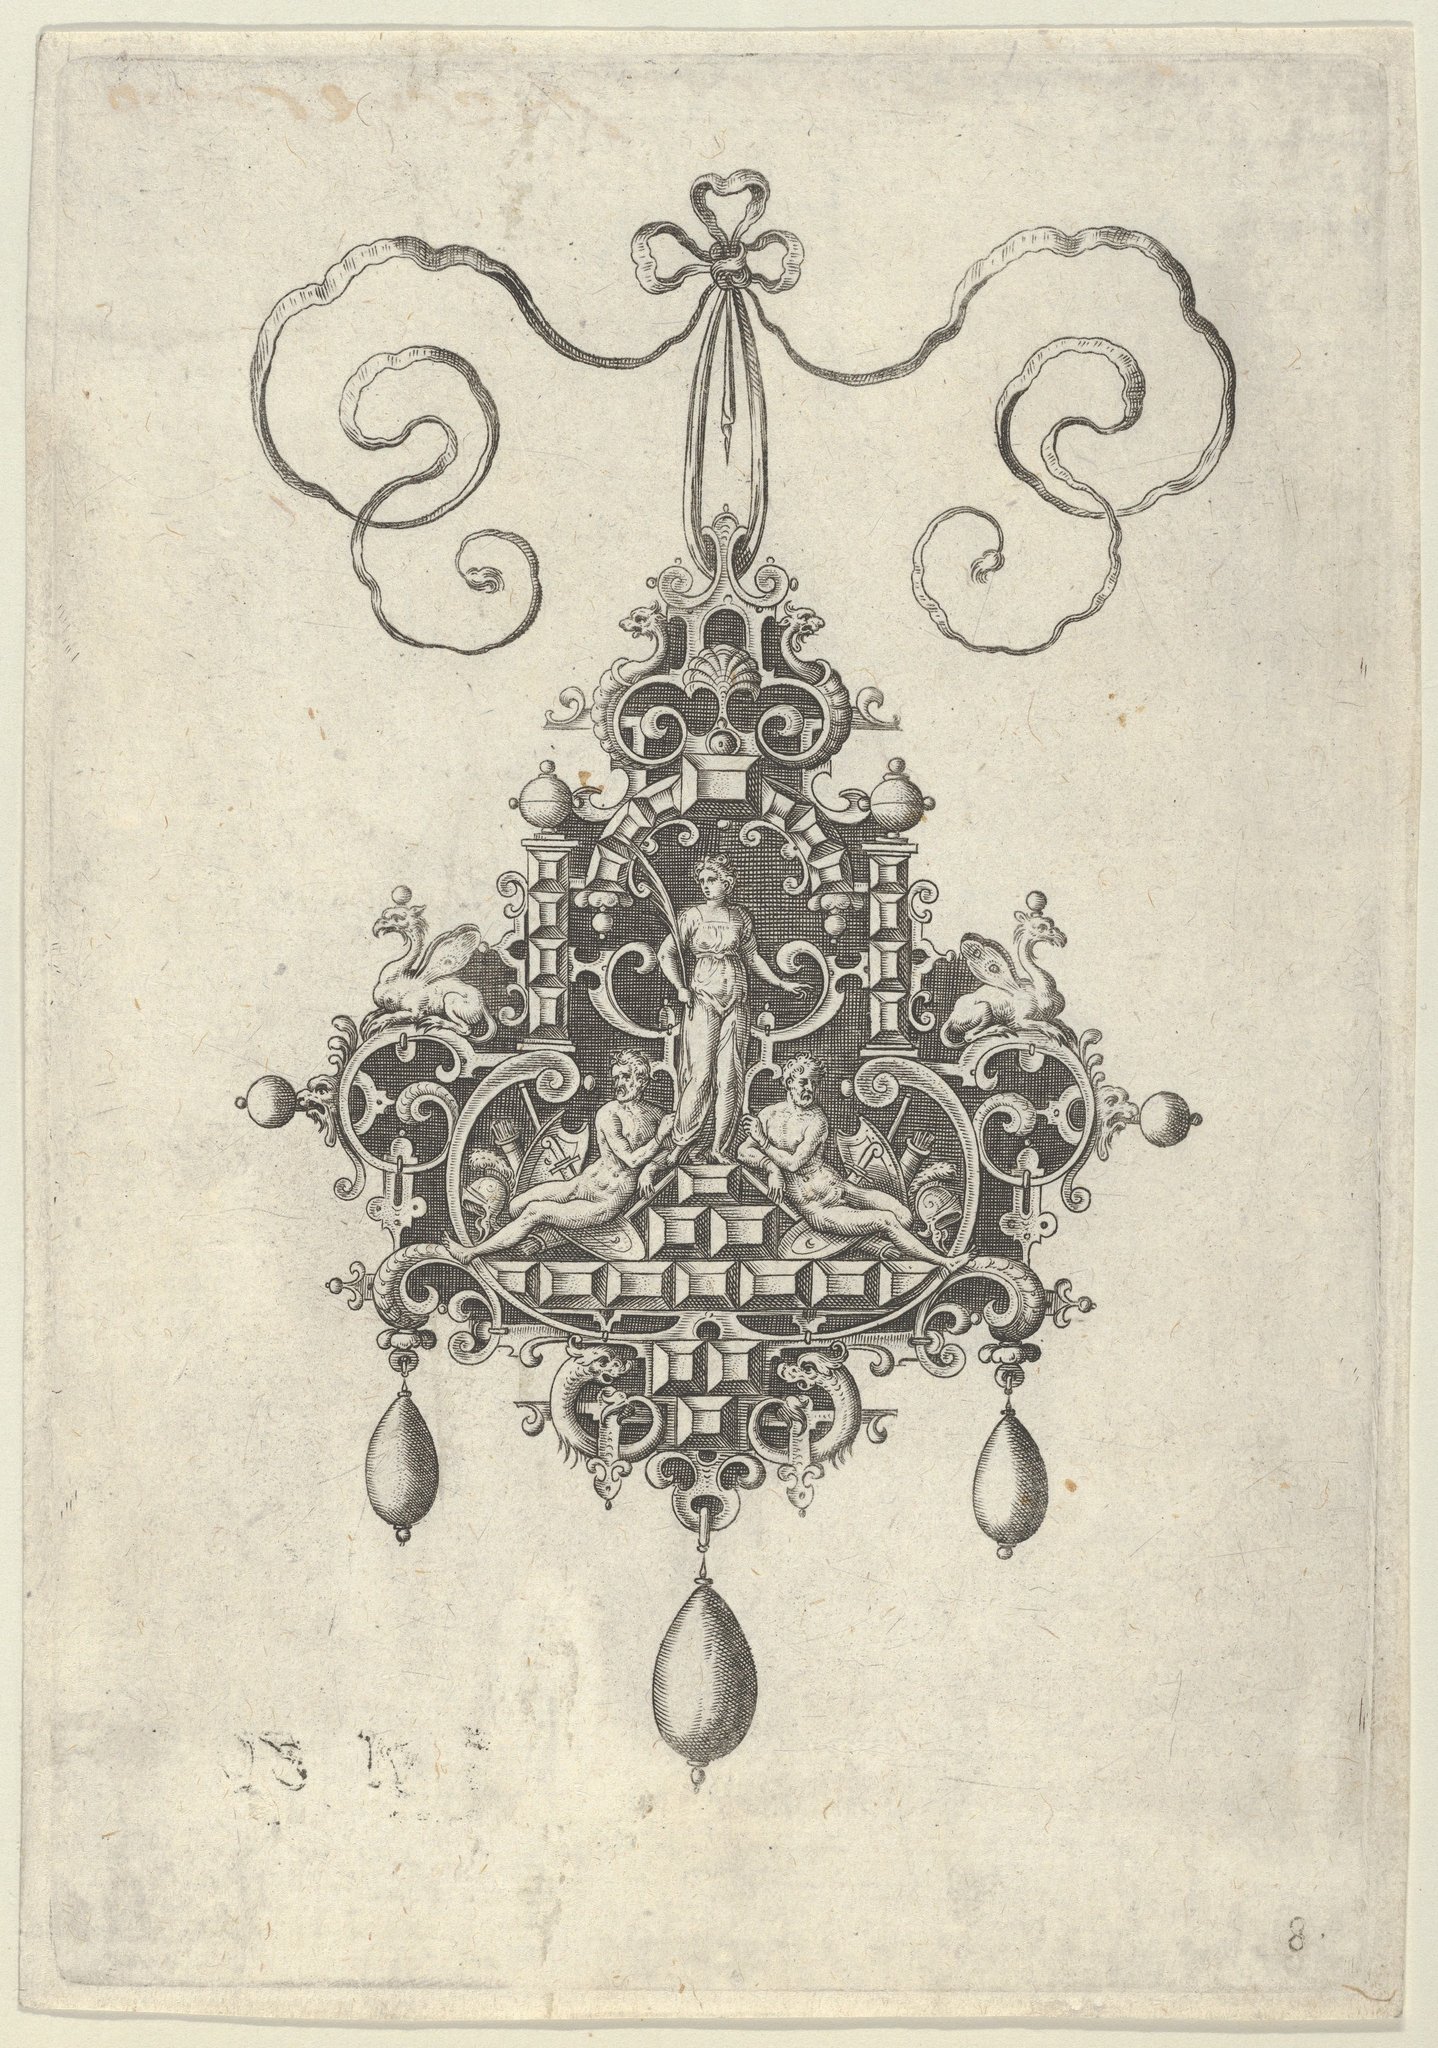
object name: print ornament architecture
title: Pendant Design with a Peace-Goddess Flanked by Two Warriors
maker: jan collaert i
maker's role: artist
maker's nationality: netherlandish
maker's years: 1530-1581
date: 1581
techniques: engraving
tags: pendants,male nudes,goddess